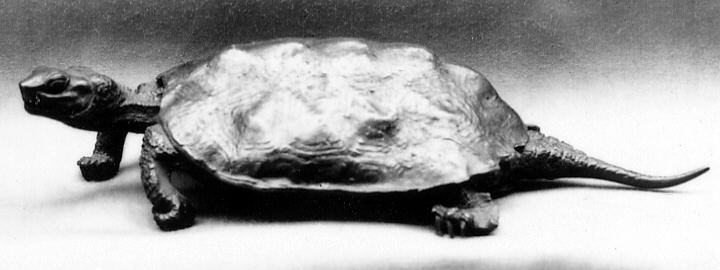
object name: ornament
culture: japanese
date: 1801-1900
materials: bronze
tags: turtles